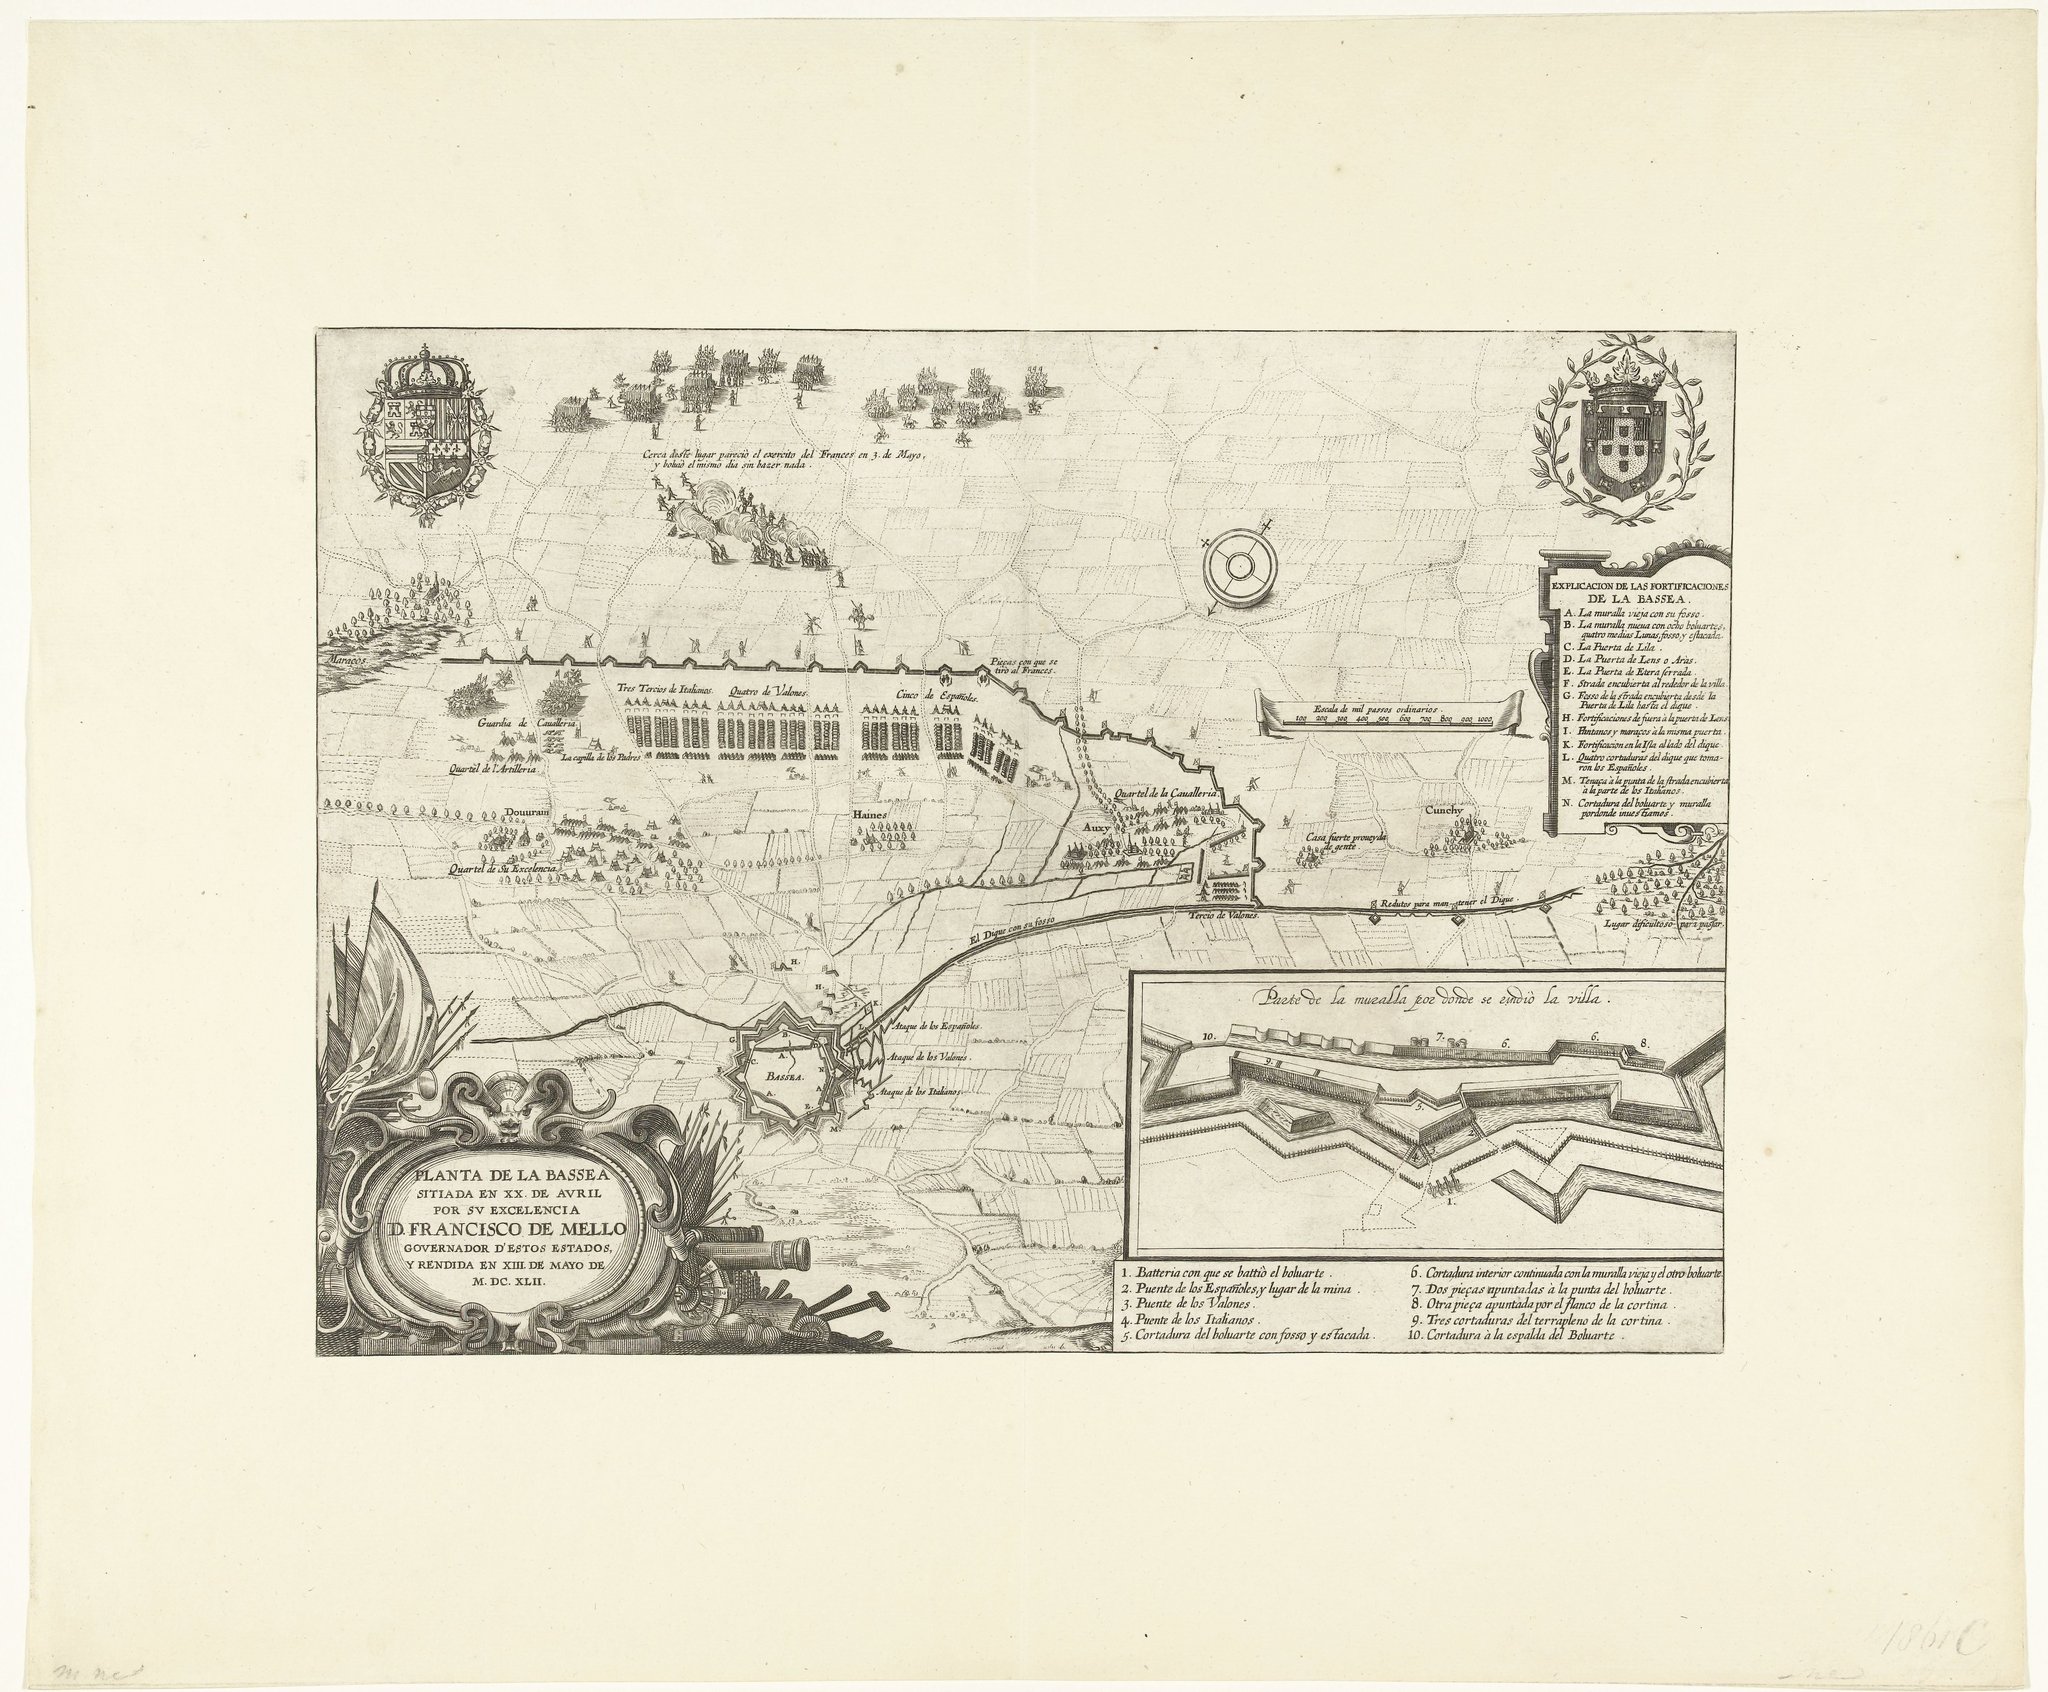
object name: print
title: Herovering van La Bassée door Francisco de Melo, 1642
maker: Anonymous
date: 1642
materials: paper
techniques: engraving, etching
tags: maps of separate countries or regions, siege, position war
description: Kaart met de herovering van de vestingstad La Bassée door het Spaanse leger onder landvoogd Francisco de Melo op 11 mei na een belegering begonnen op 19 april 1642. Centraal de versterkte stad, boven de stad het legerkamp van de belegerende troepen. Bovenaan de wapens van de koning van Spanje en van Portugal. Rechts de legenda A-N in het Spaans. Rechtsonder een detail van de vestingmuren met de legenda 1-10. Alle opschriften in het Spaans.